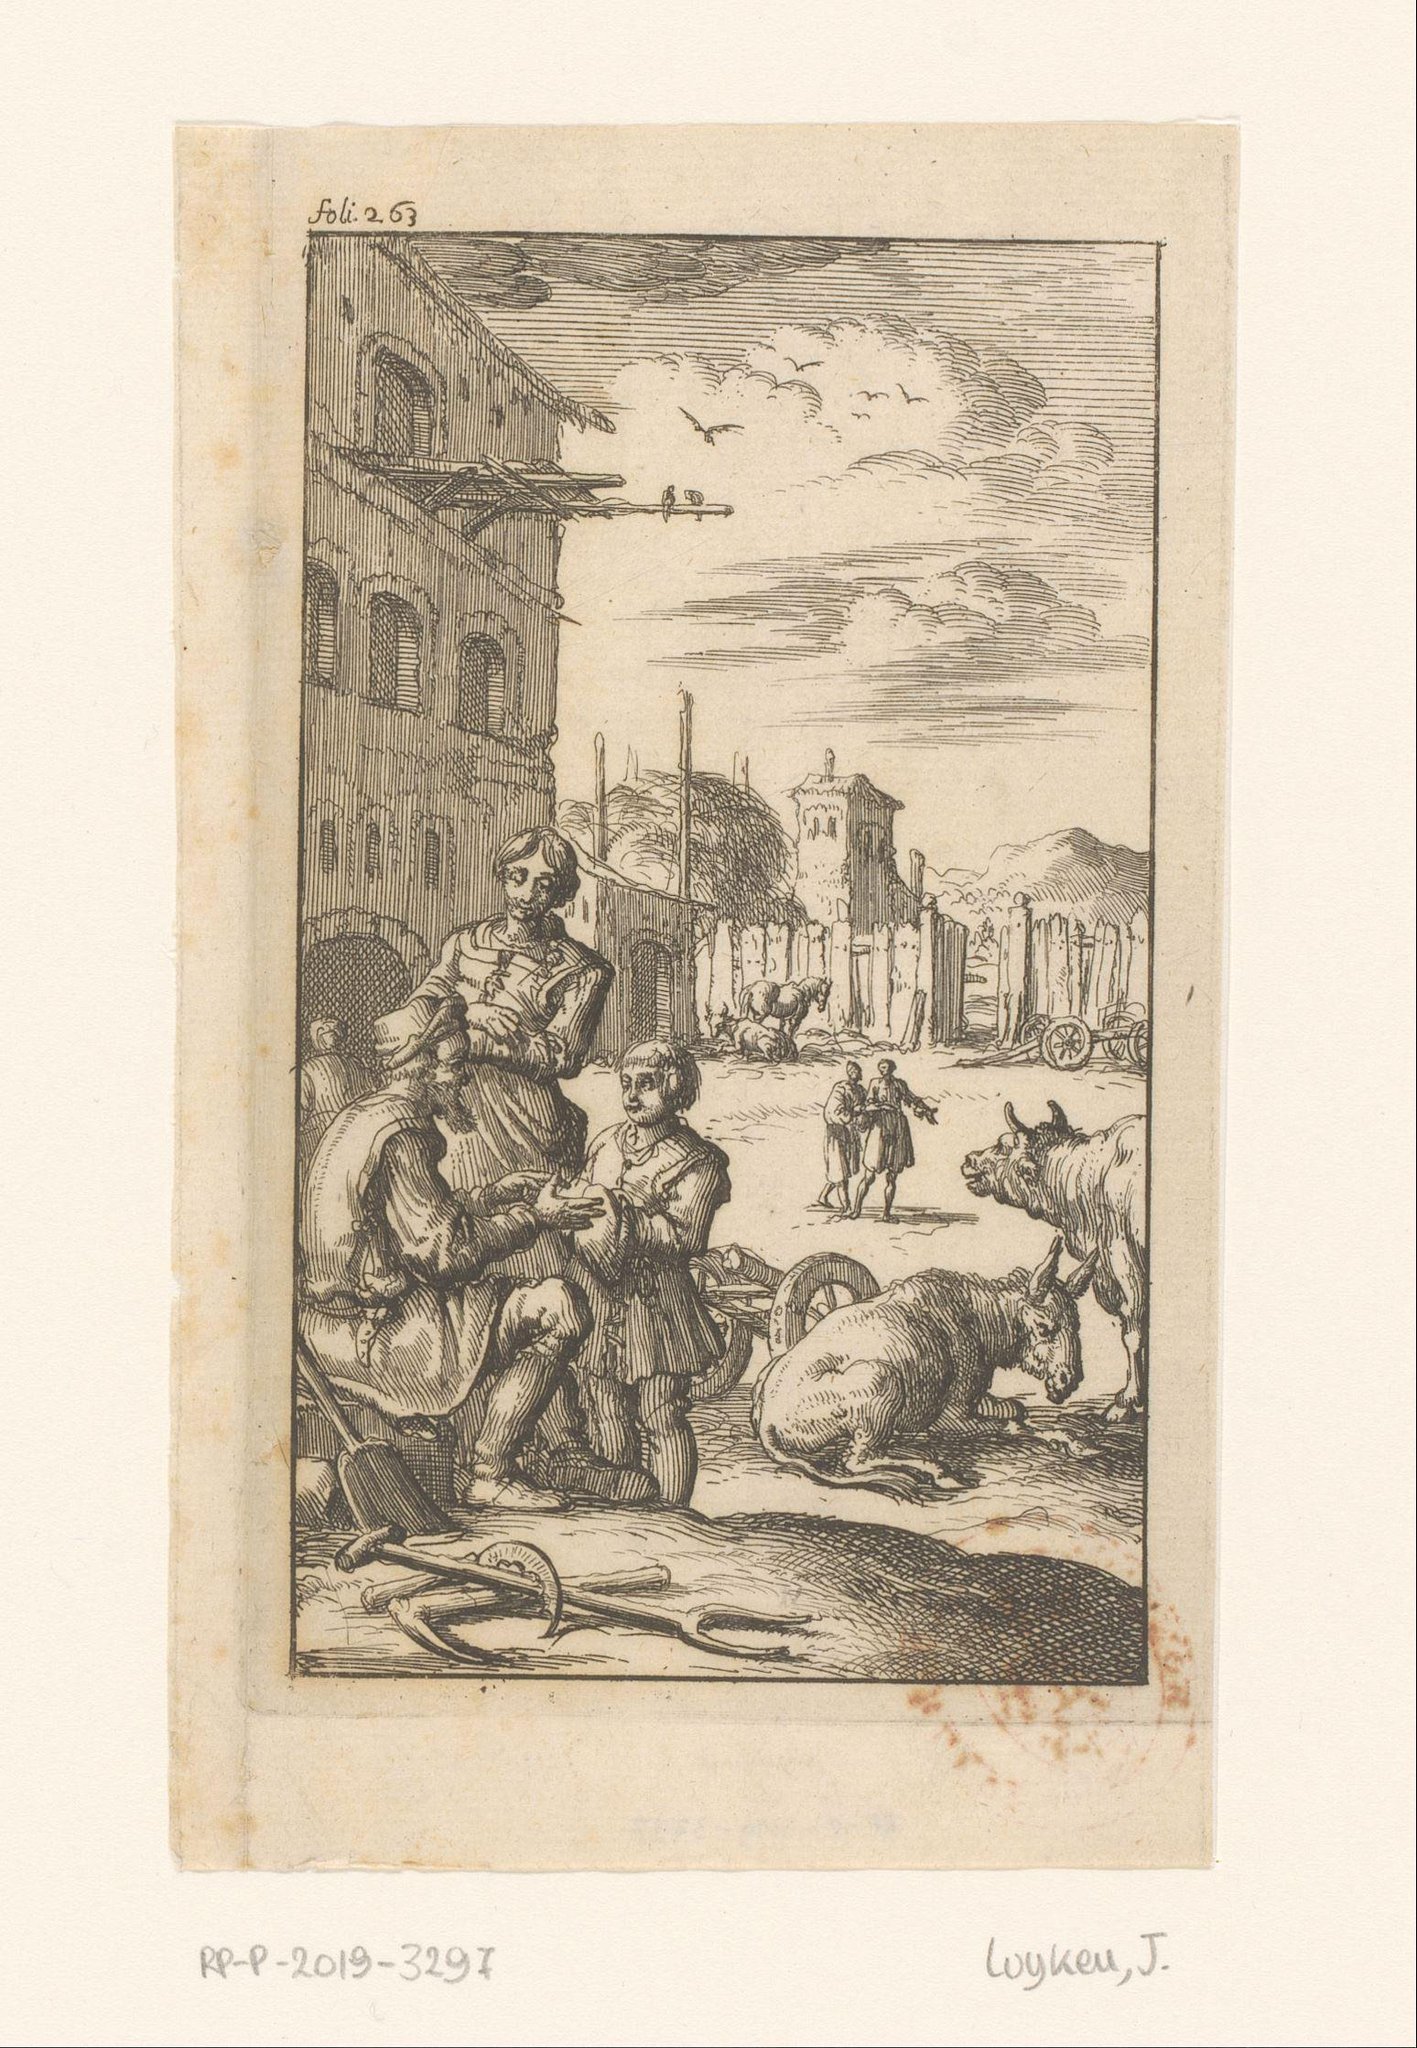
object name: book illustration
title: Gedenk de sabbatdag: het derde Gebod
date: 1685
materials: paper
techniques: etching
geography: amsterdam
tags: mother and baby or young child, the ten commandments (exodus 20:3-17), 'remember the sabbath day' ~ separate representation of the fourth of the ten commandments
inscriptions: collector's mark: Lugt 240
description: Prent uit: Hondorffius, Andreas. De tien geboden des Heeren (...). Amsterdam: Jan Bouman, 1685.